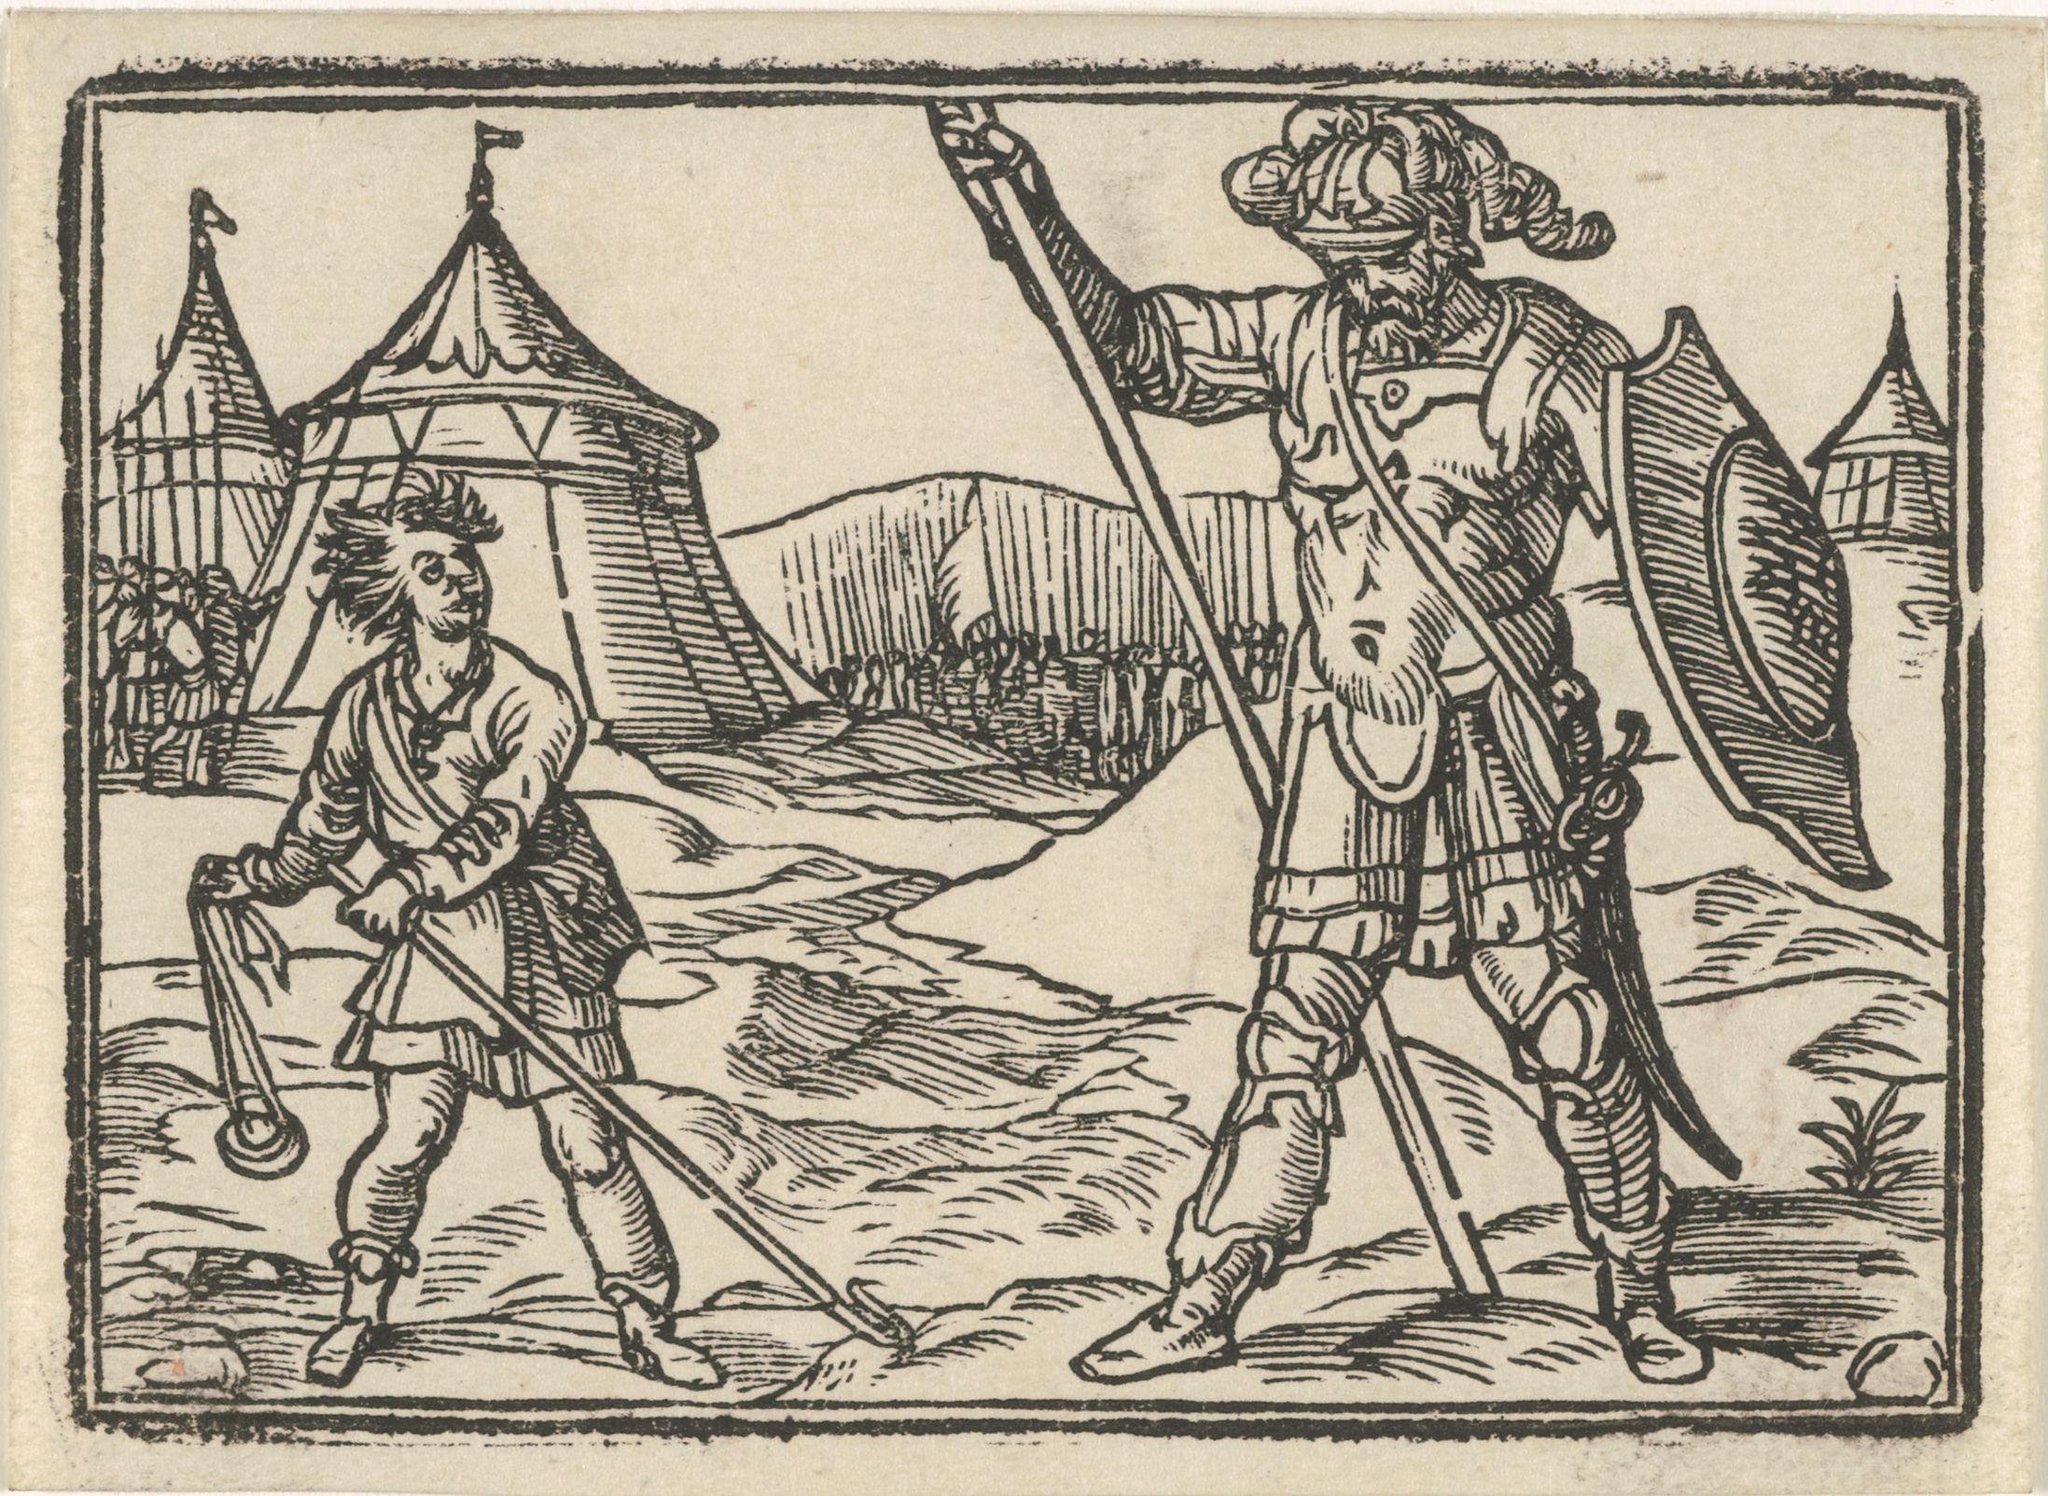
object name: print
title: David en Goliat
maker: dirck de bray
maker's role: draughtsman, painter, print maker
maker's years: 1625-1694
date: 1635-1694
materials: paper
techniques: woodcut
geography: netherlands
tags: david fighting goliath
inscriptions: collector's mark: Lugt 240